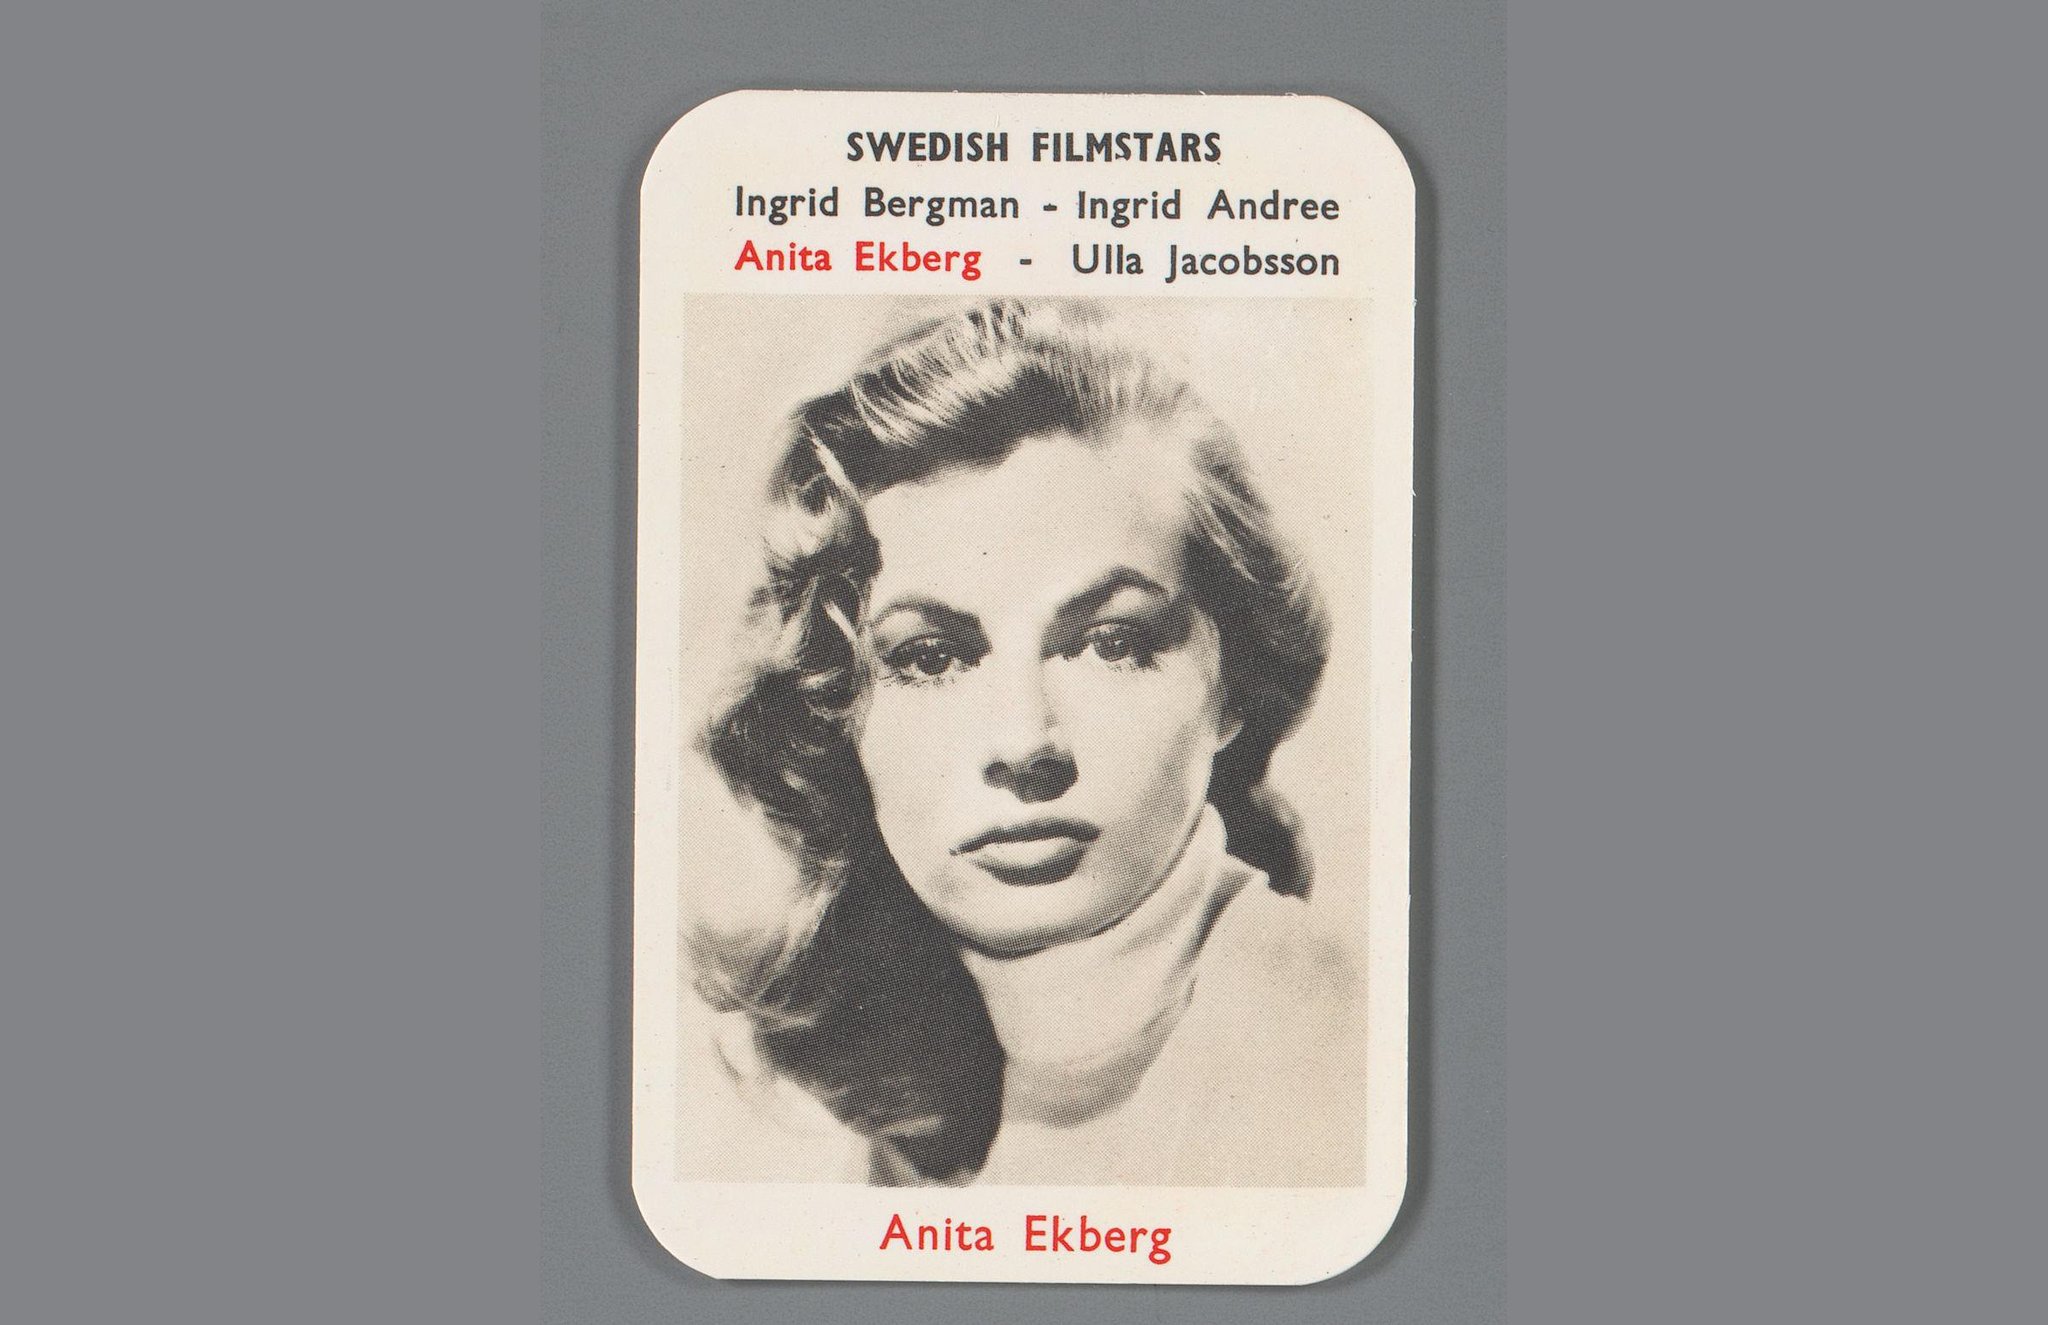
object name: photomechanical print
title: Anita Ekberg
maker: Anonymous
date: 1960-1970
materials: paper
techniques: autotype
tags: portrait of actor, actress